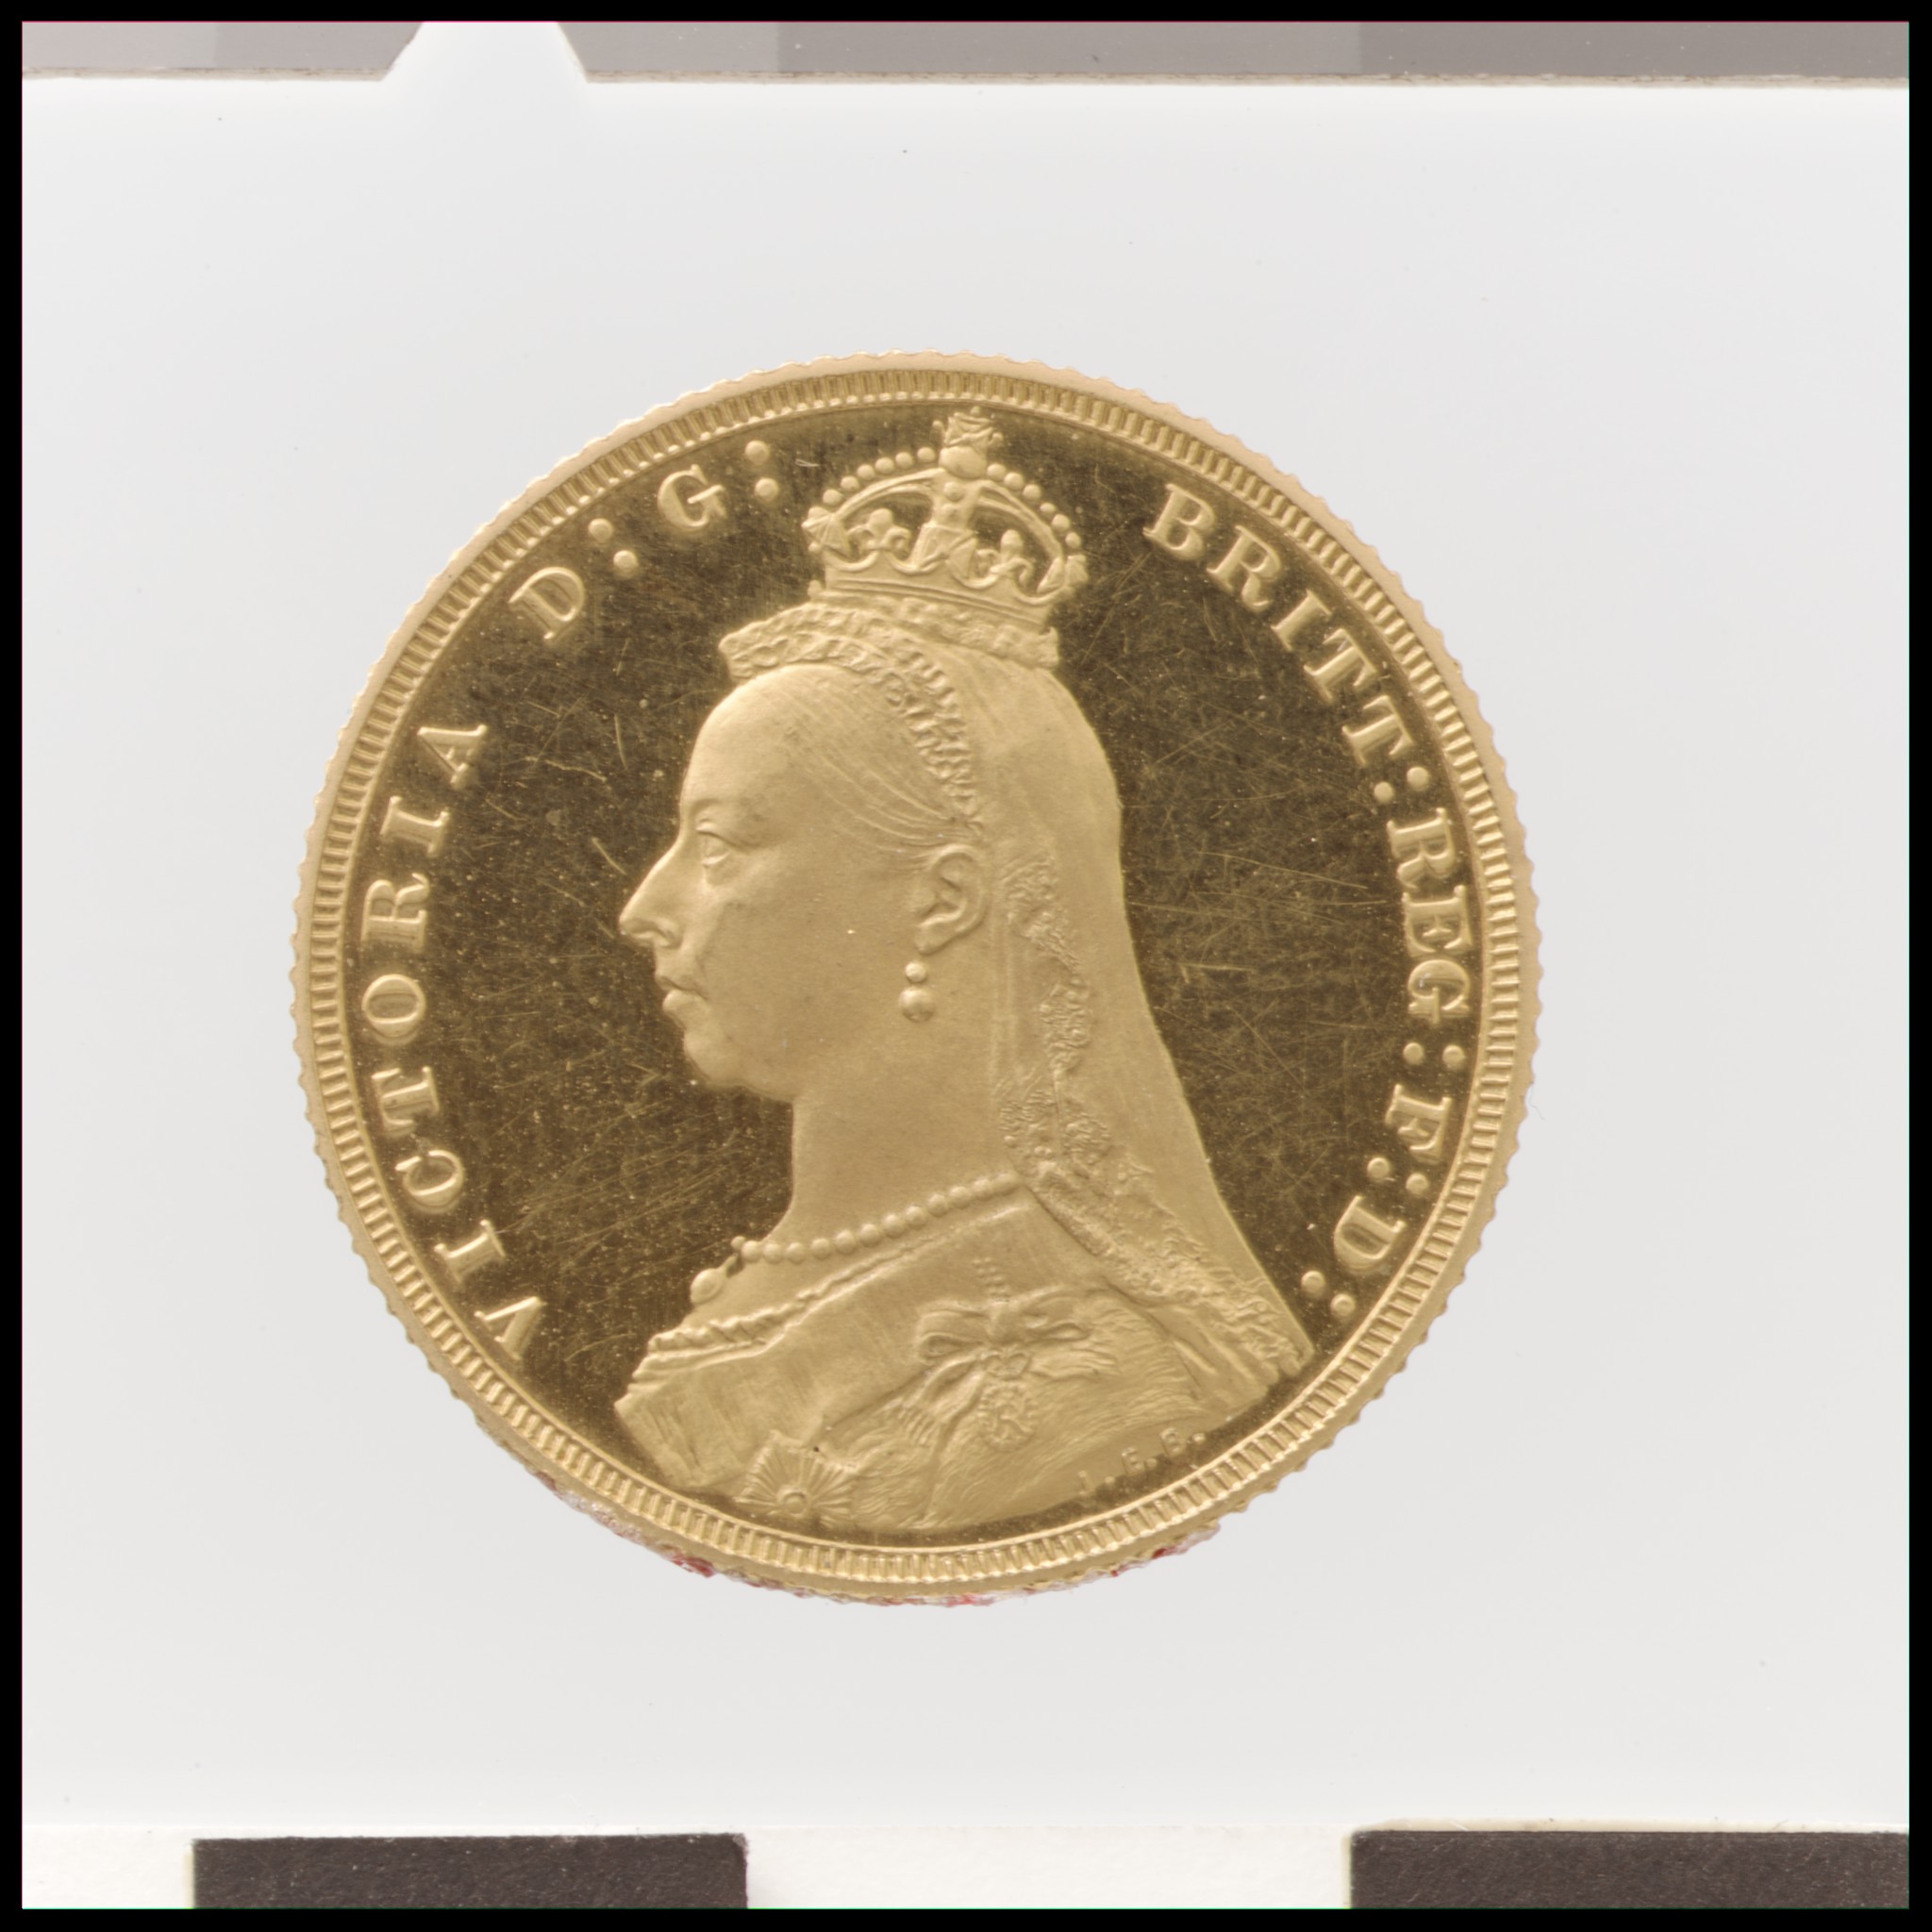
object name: proof sovereign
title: Queen Victoria "Jubilee Head" proof sovereign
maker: joseph edgar boehm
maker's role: artist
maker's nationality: british, born austria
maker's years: 1834-1890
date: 1887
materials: gold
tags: profiles,women,dragons,horses,queen victoria